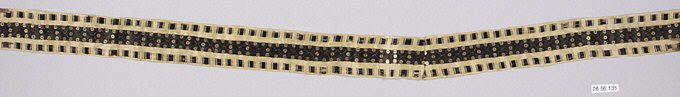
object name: ribbon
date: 1801-1833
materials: silk